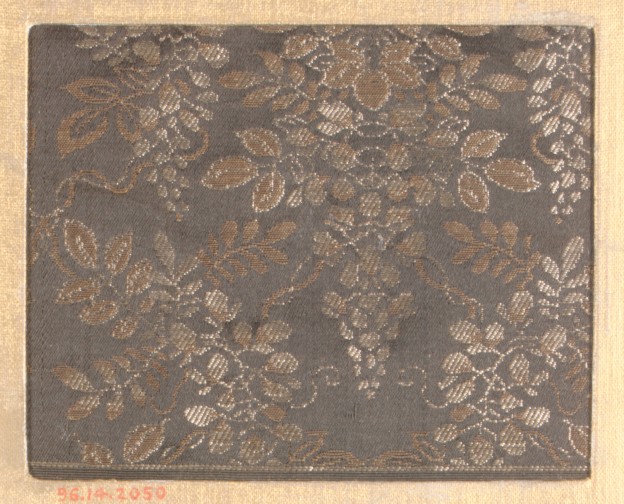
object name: piece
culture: japanese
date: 1701-1900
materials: silk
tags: flowers